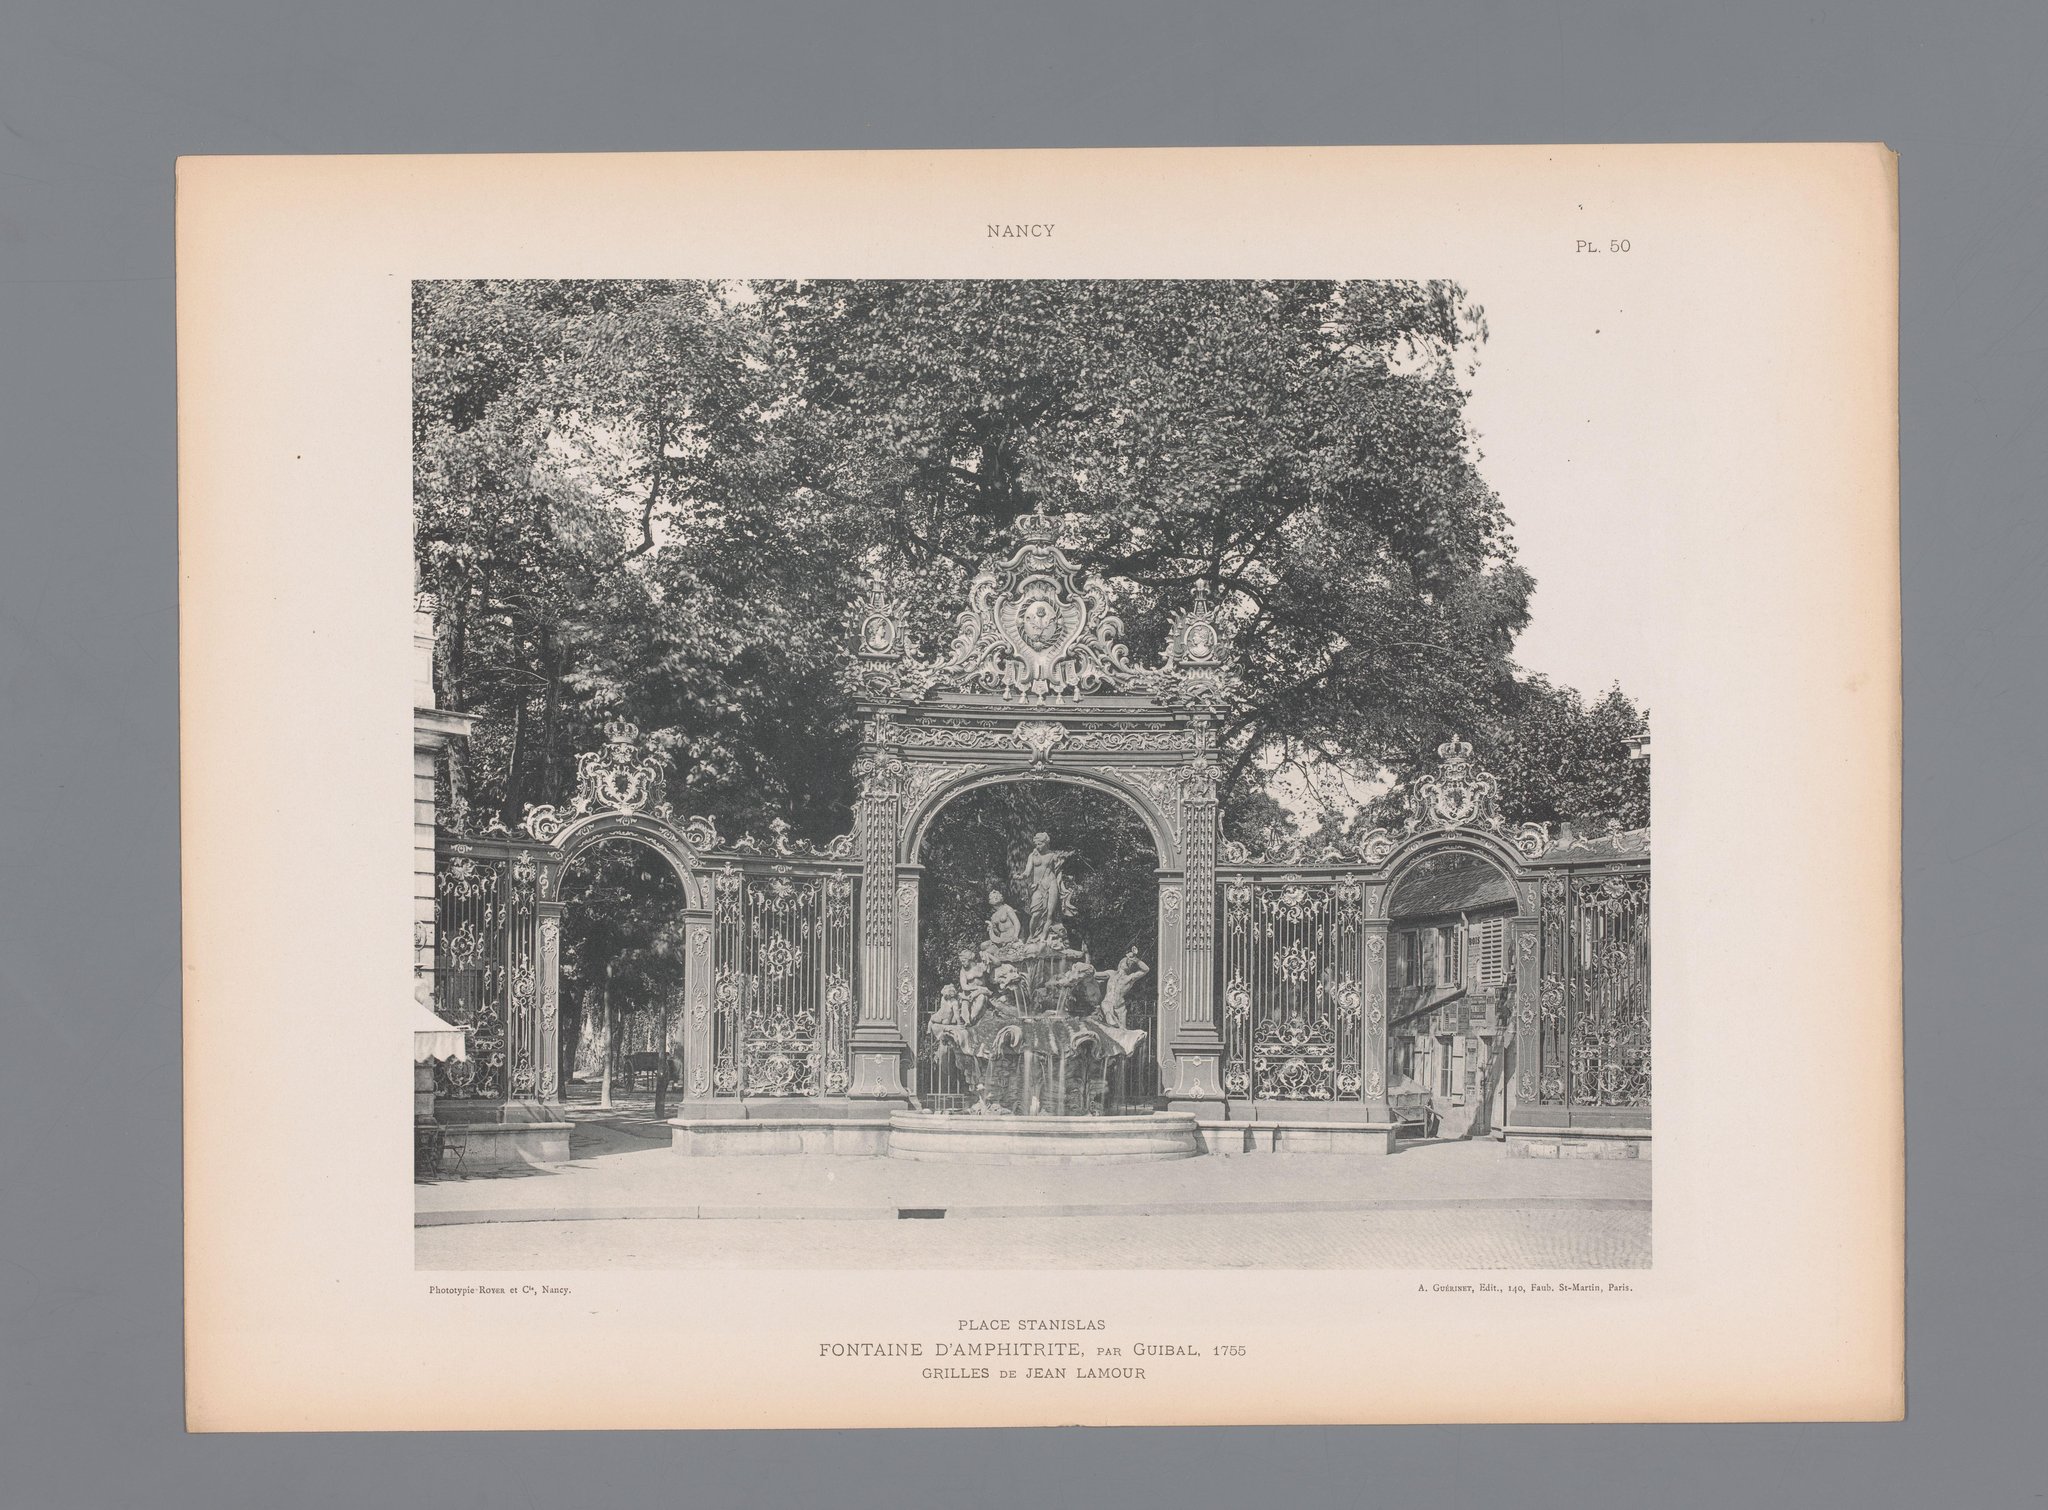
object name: photomechanical print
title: Fontein van Amphitrite op Place Stanislas te Nancy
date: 1891-1896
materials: paper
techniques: photograph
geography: paris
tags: square, place, circus, etc., (story of) amphitrite, ornamental fountain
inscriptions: inscription: ‘Place Stanislas/ Fontaine d'Amphitrite, par Guibal, 1755/ Grilles de Jean Lamour’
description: Deze prent maakt deel uit van een omslag met 103 prenten op 101 bladen en een titelblad.